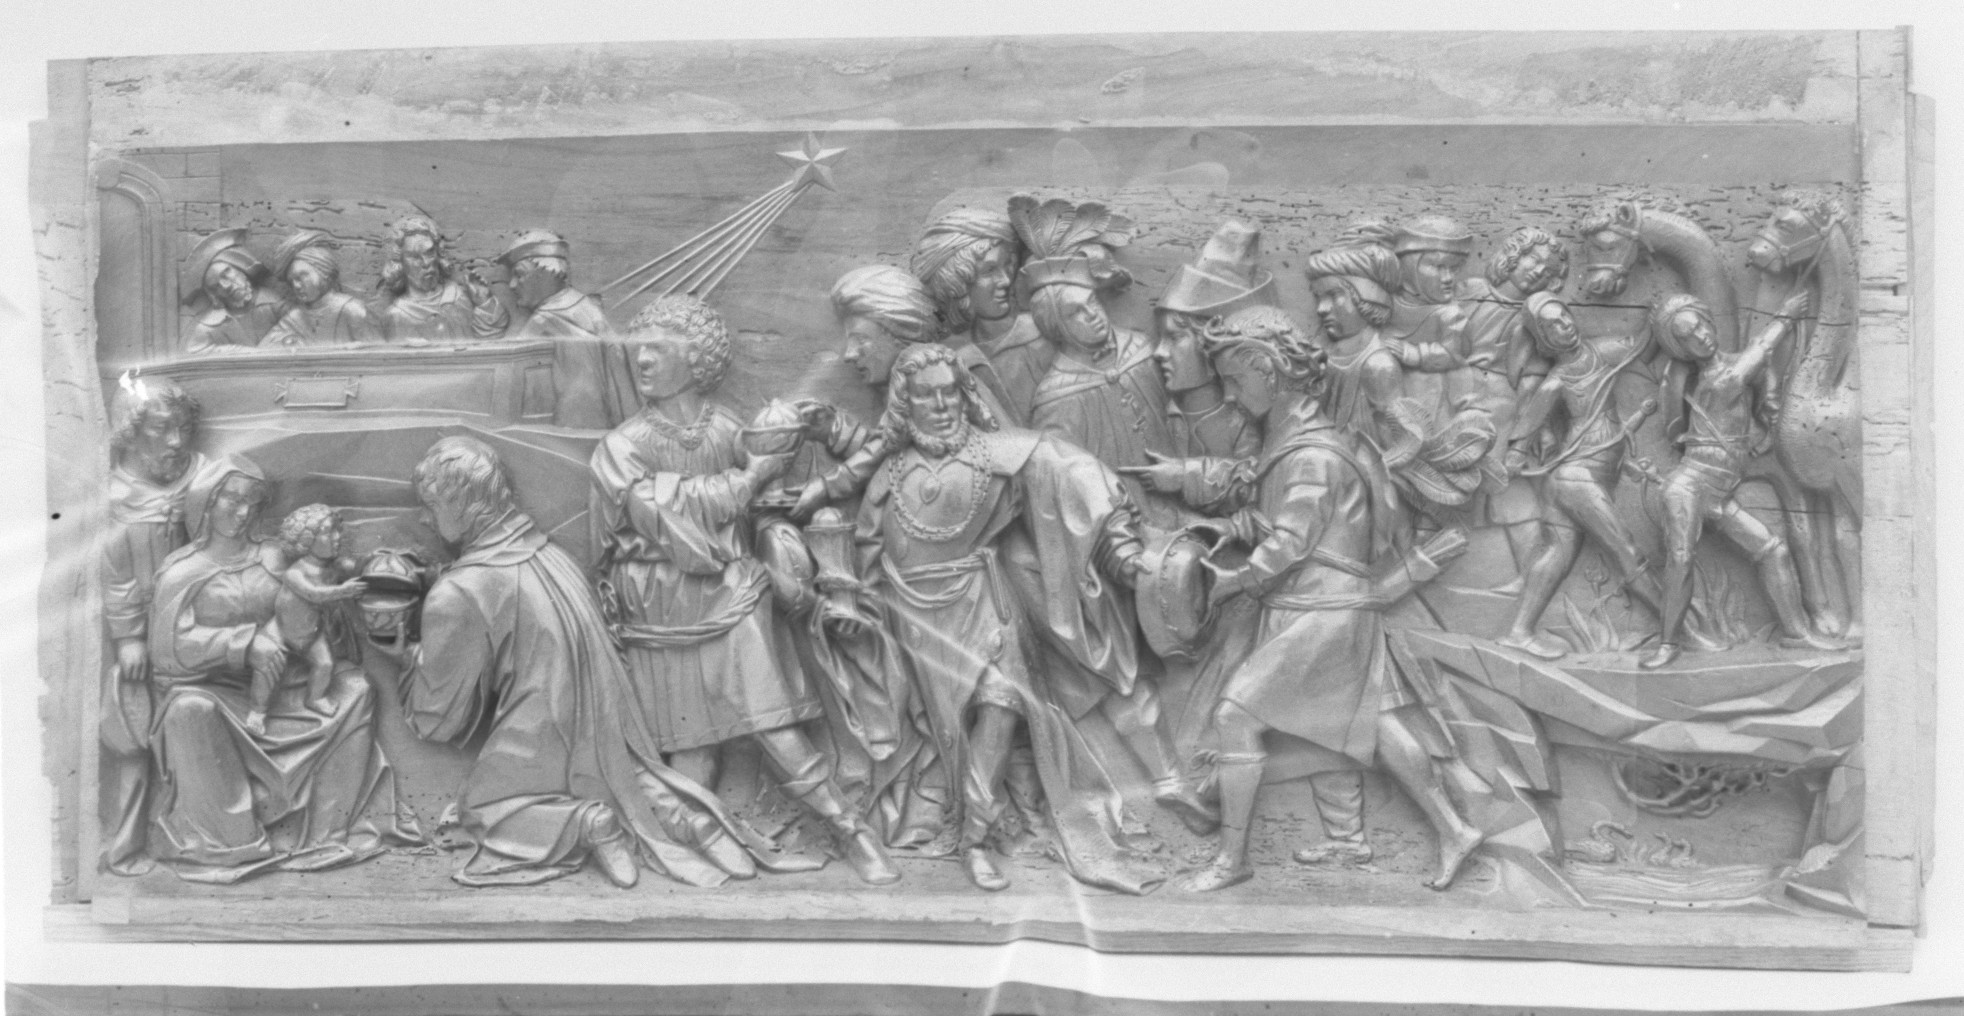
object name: chest front panel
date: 1501-1550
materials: wood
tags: infants,men,women,camels